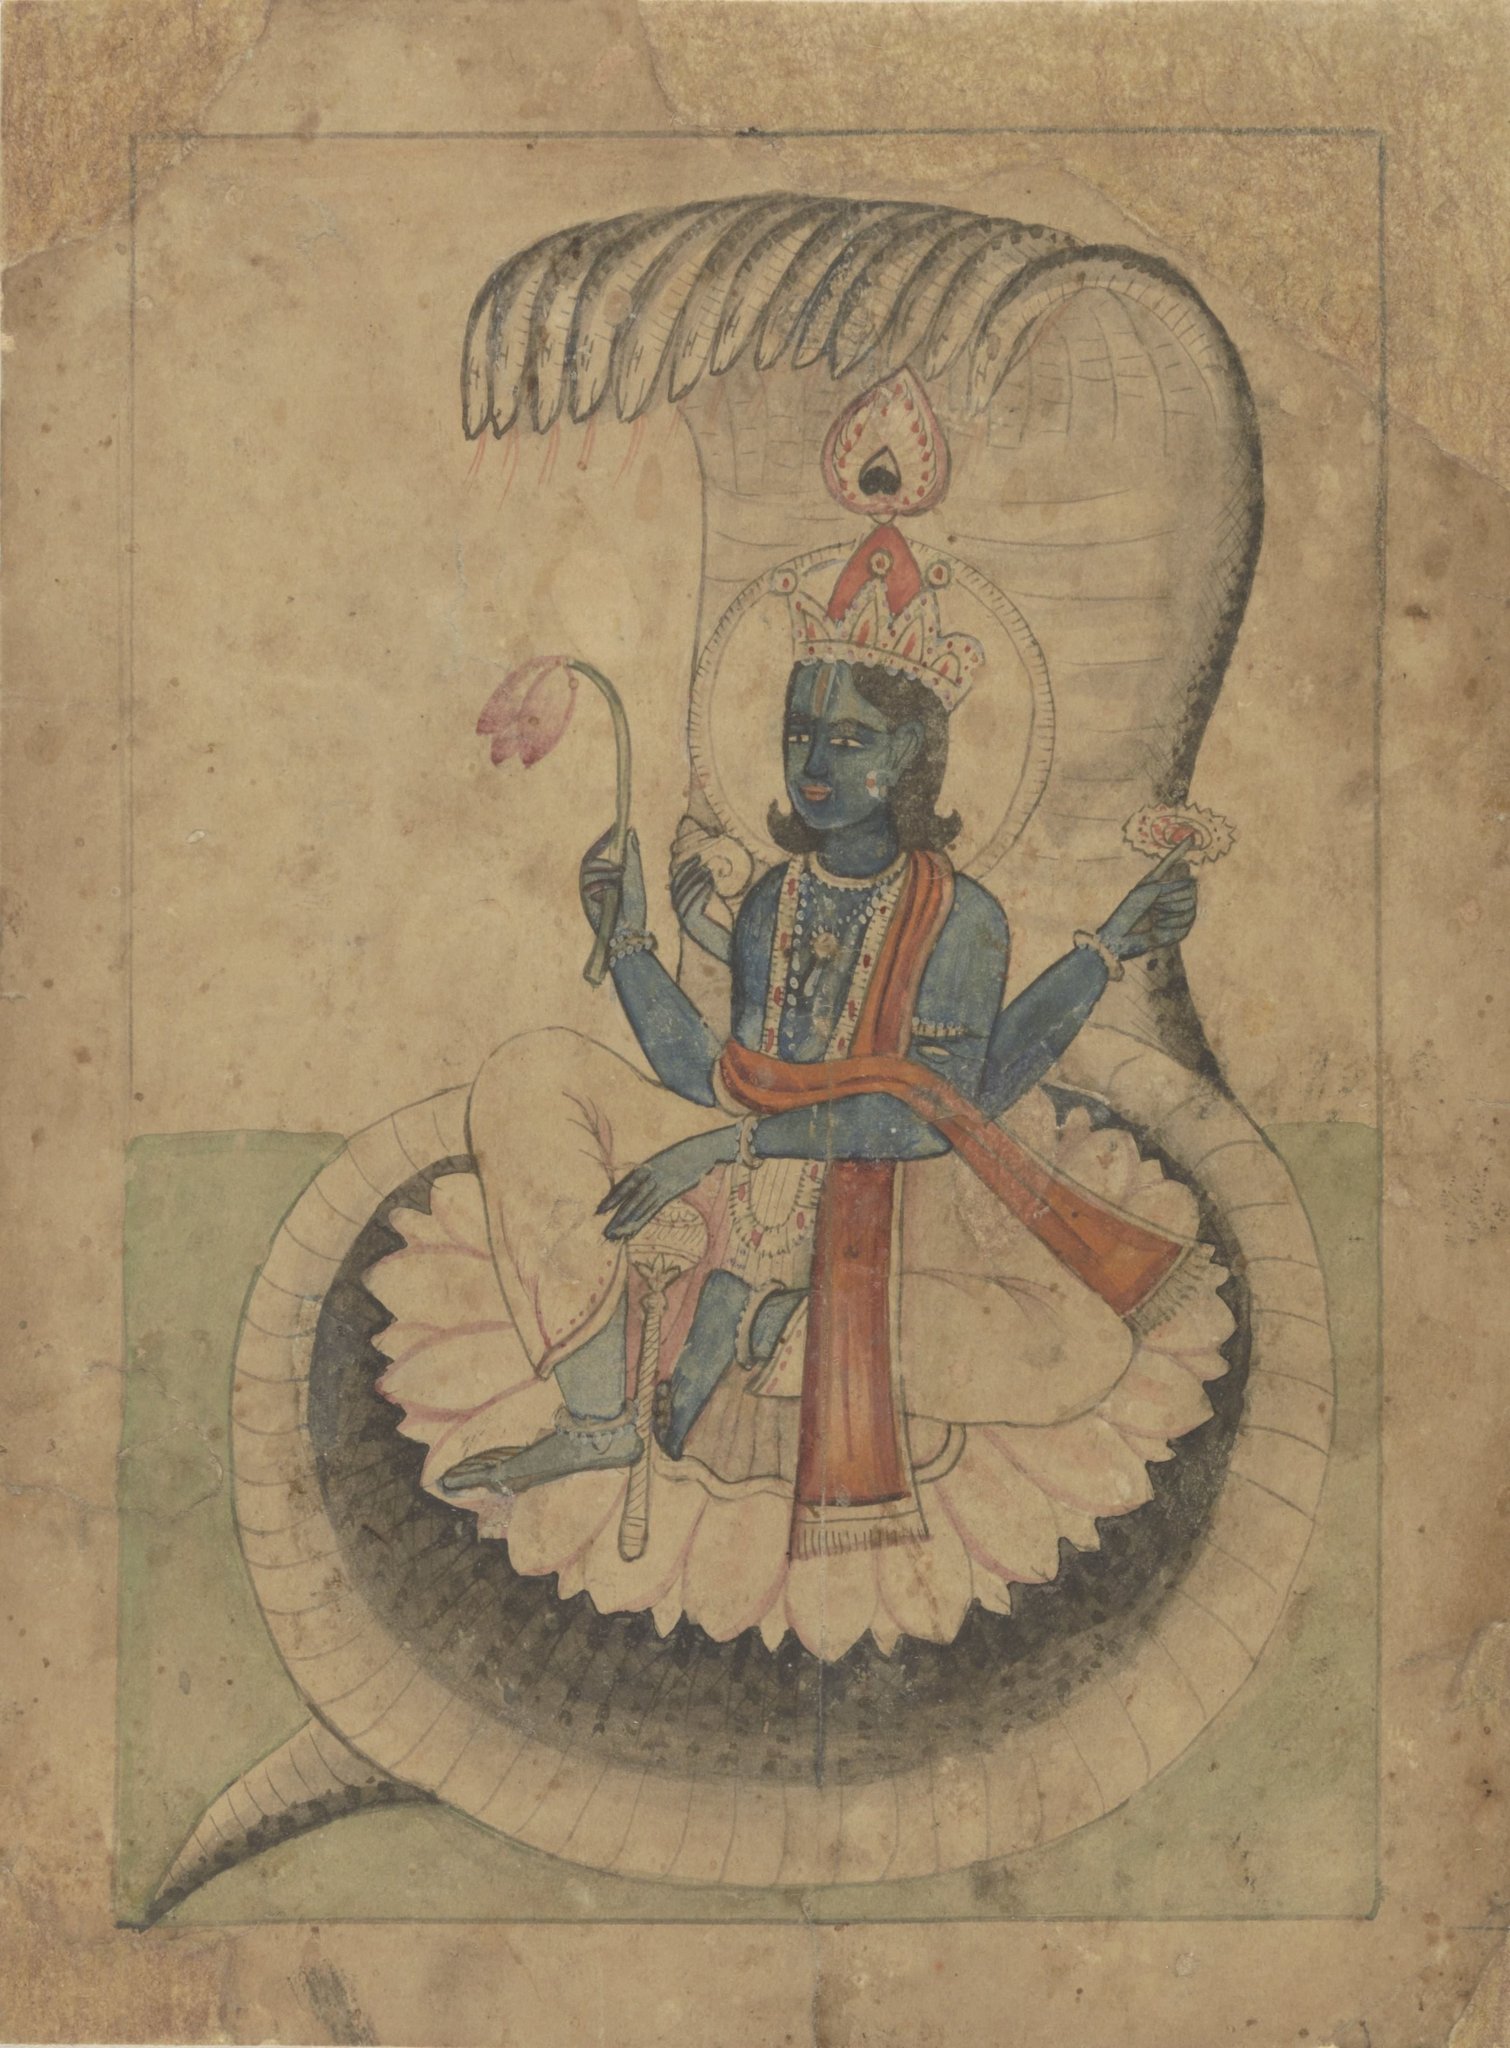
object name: drawing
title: Krishna op zijn troon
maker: Anonymous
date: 1800-1900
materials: paper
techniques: brush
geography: nepal